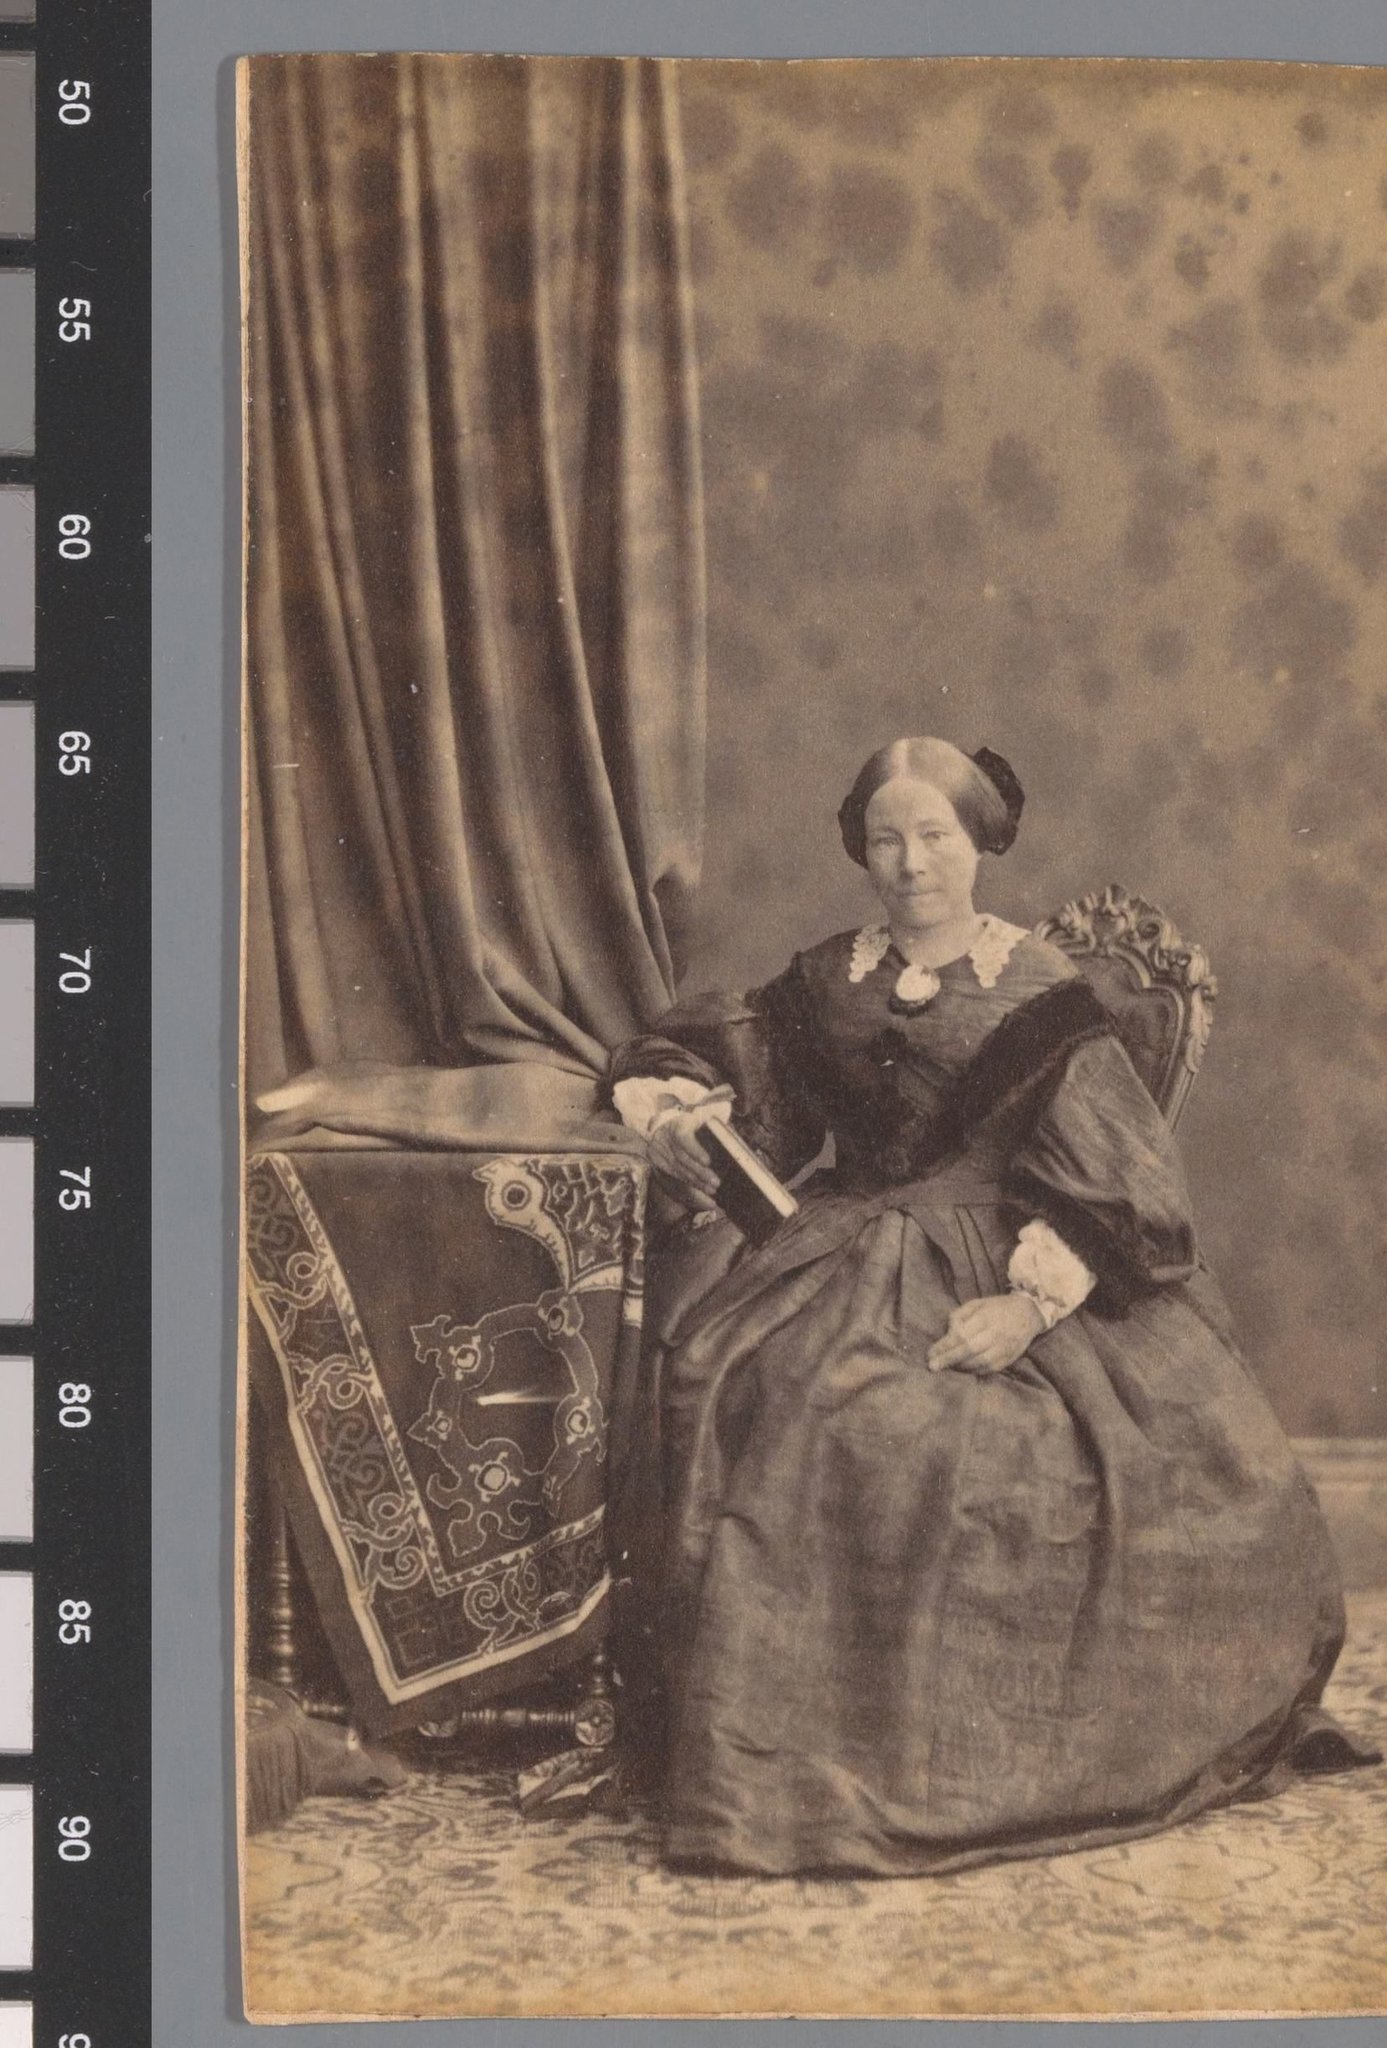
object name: carte de visite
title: Portret van een vrouw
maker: robert severin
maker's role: fotograaf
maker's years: 1839-1888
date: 1861-1864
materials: cardboard, paper, photographic support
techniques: albumen print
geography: the hague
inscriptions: address: ‘R. Severin/Photographe du Roi/109, Noordeinde/La Haye’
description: Vrouw met boek in de hand, zittend naast een tafel waarover een kleed met grote patronen. Links achter haar een gordijn.